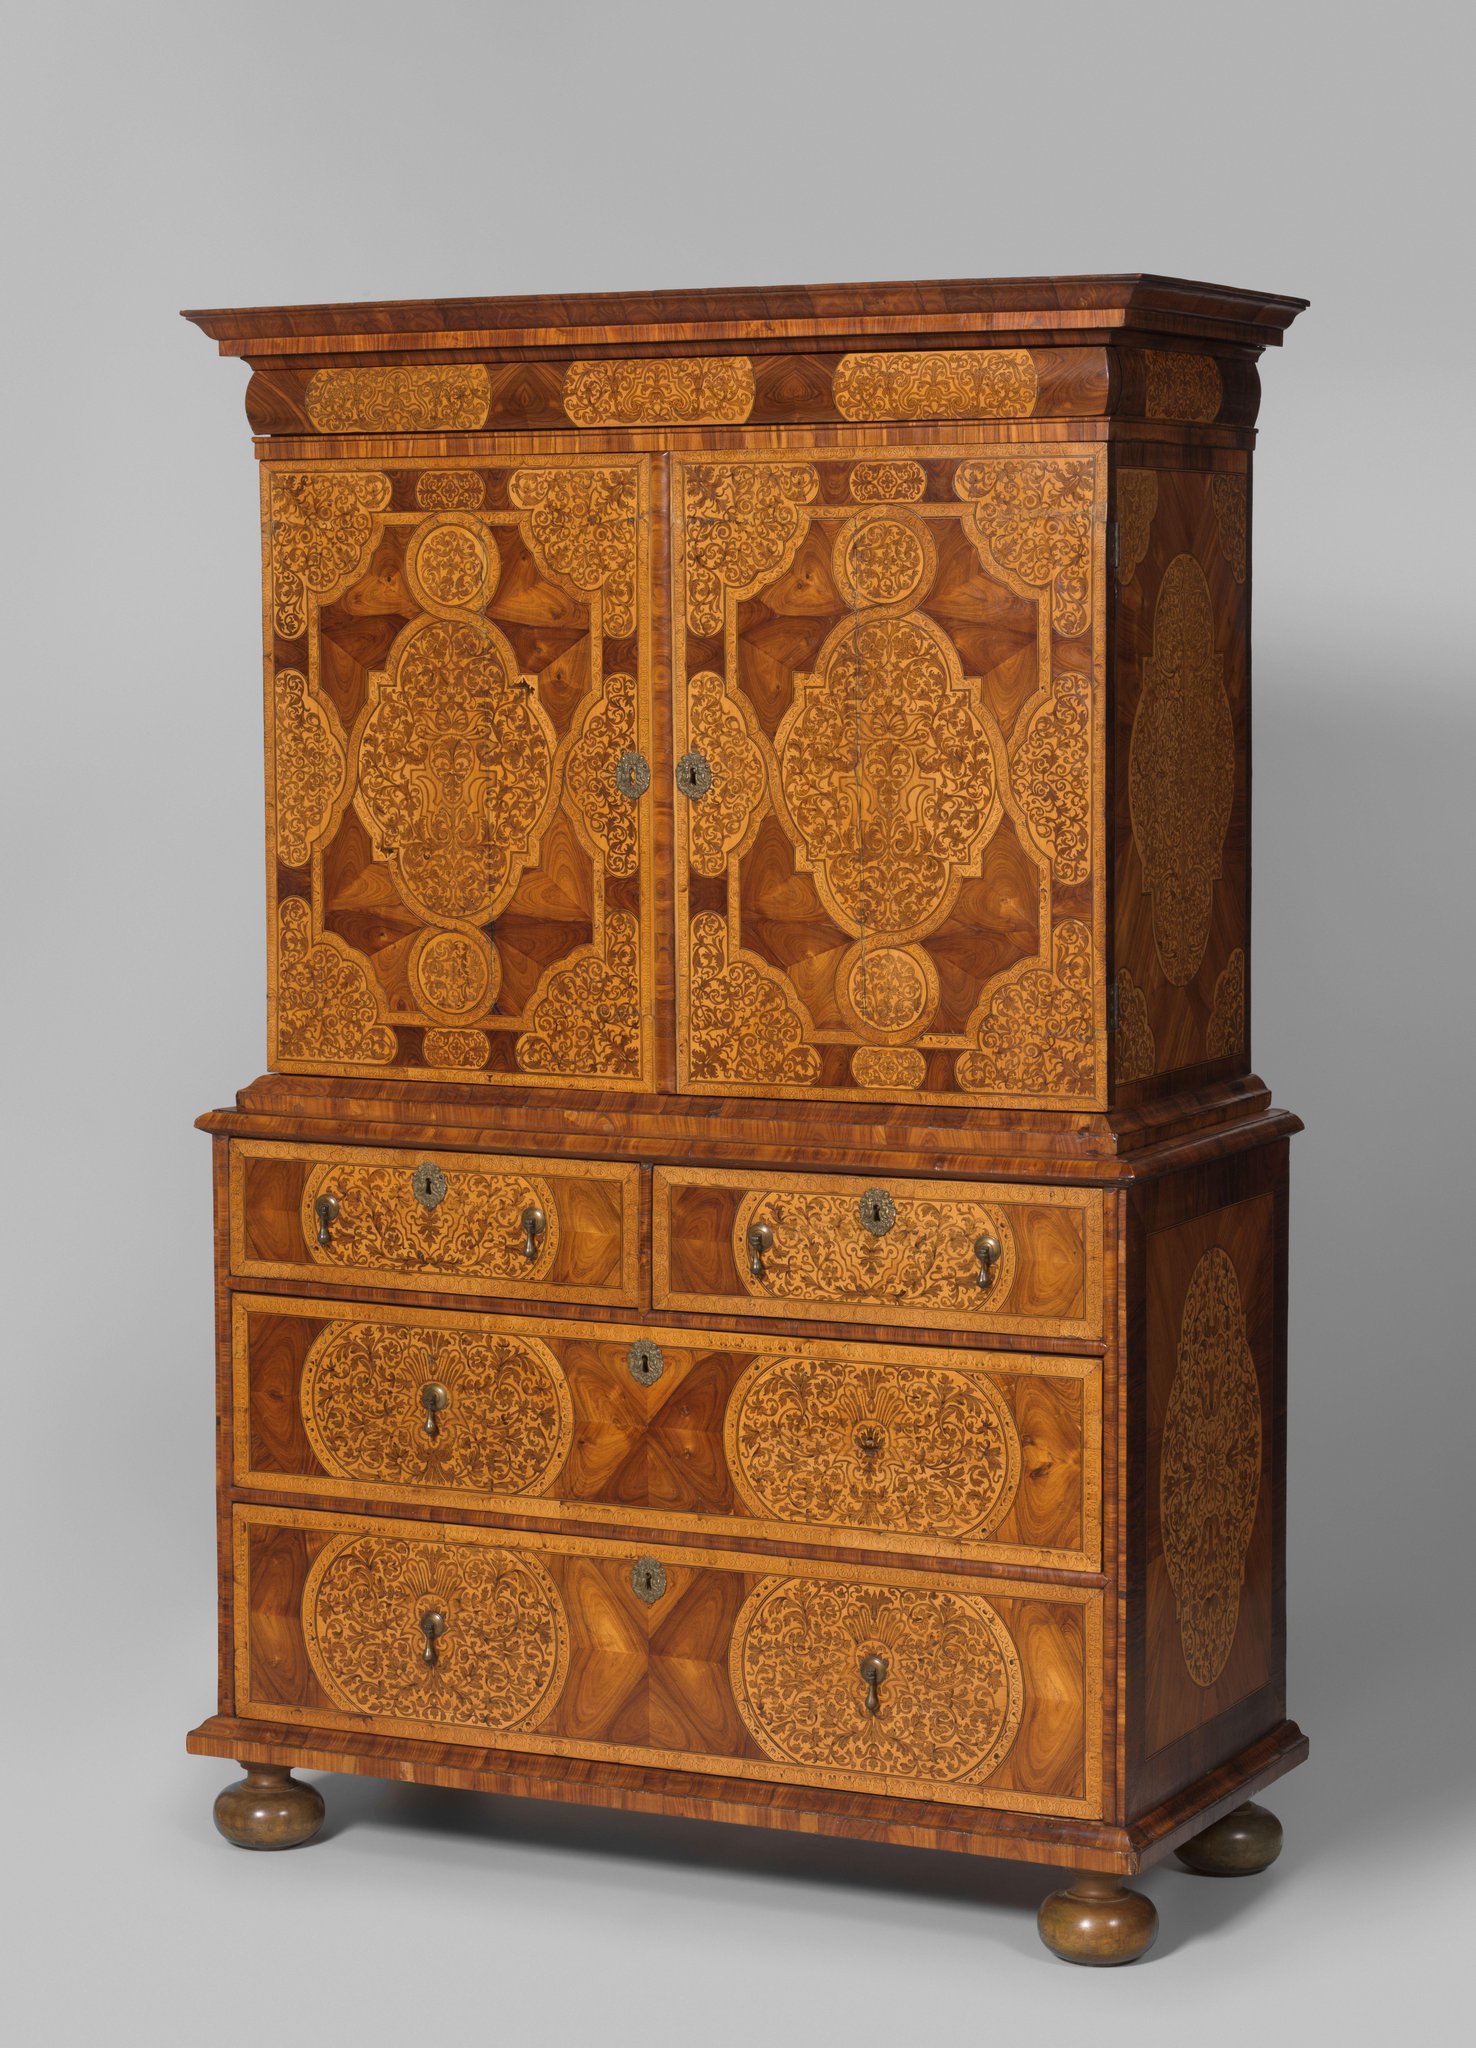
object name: furniture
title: Kast, versierd met marqueterie en bestaande uit een onderkast met twee grote en twee kleine laden en een bovenkast met twee deuren.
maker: Anonymous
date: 1690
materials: wood, copper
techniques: marquetry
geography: great britain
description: Kast versierd met marqueterie. De onderkast bevat twee grote en twee kleine laden, omgeven door een bladrand. De zijkanten tonen uitgeschulpte velden met een rozet, waaromheen acanthusbladvoluten. De laden en de twee deuren en zijkanten van de bovenkast tonen velden met een schelpvormig motief in het midden, omgeven door symmetrische acanthusbladranken. De uitgeschulpte en cirkelvormige velden op de deuren zijn verbonden door een als vlechtband behandelde bladrand. Fries met lade, versierd met drie velden.